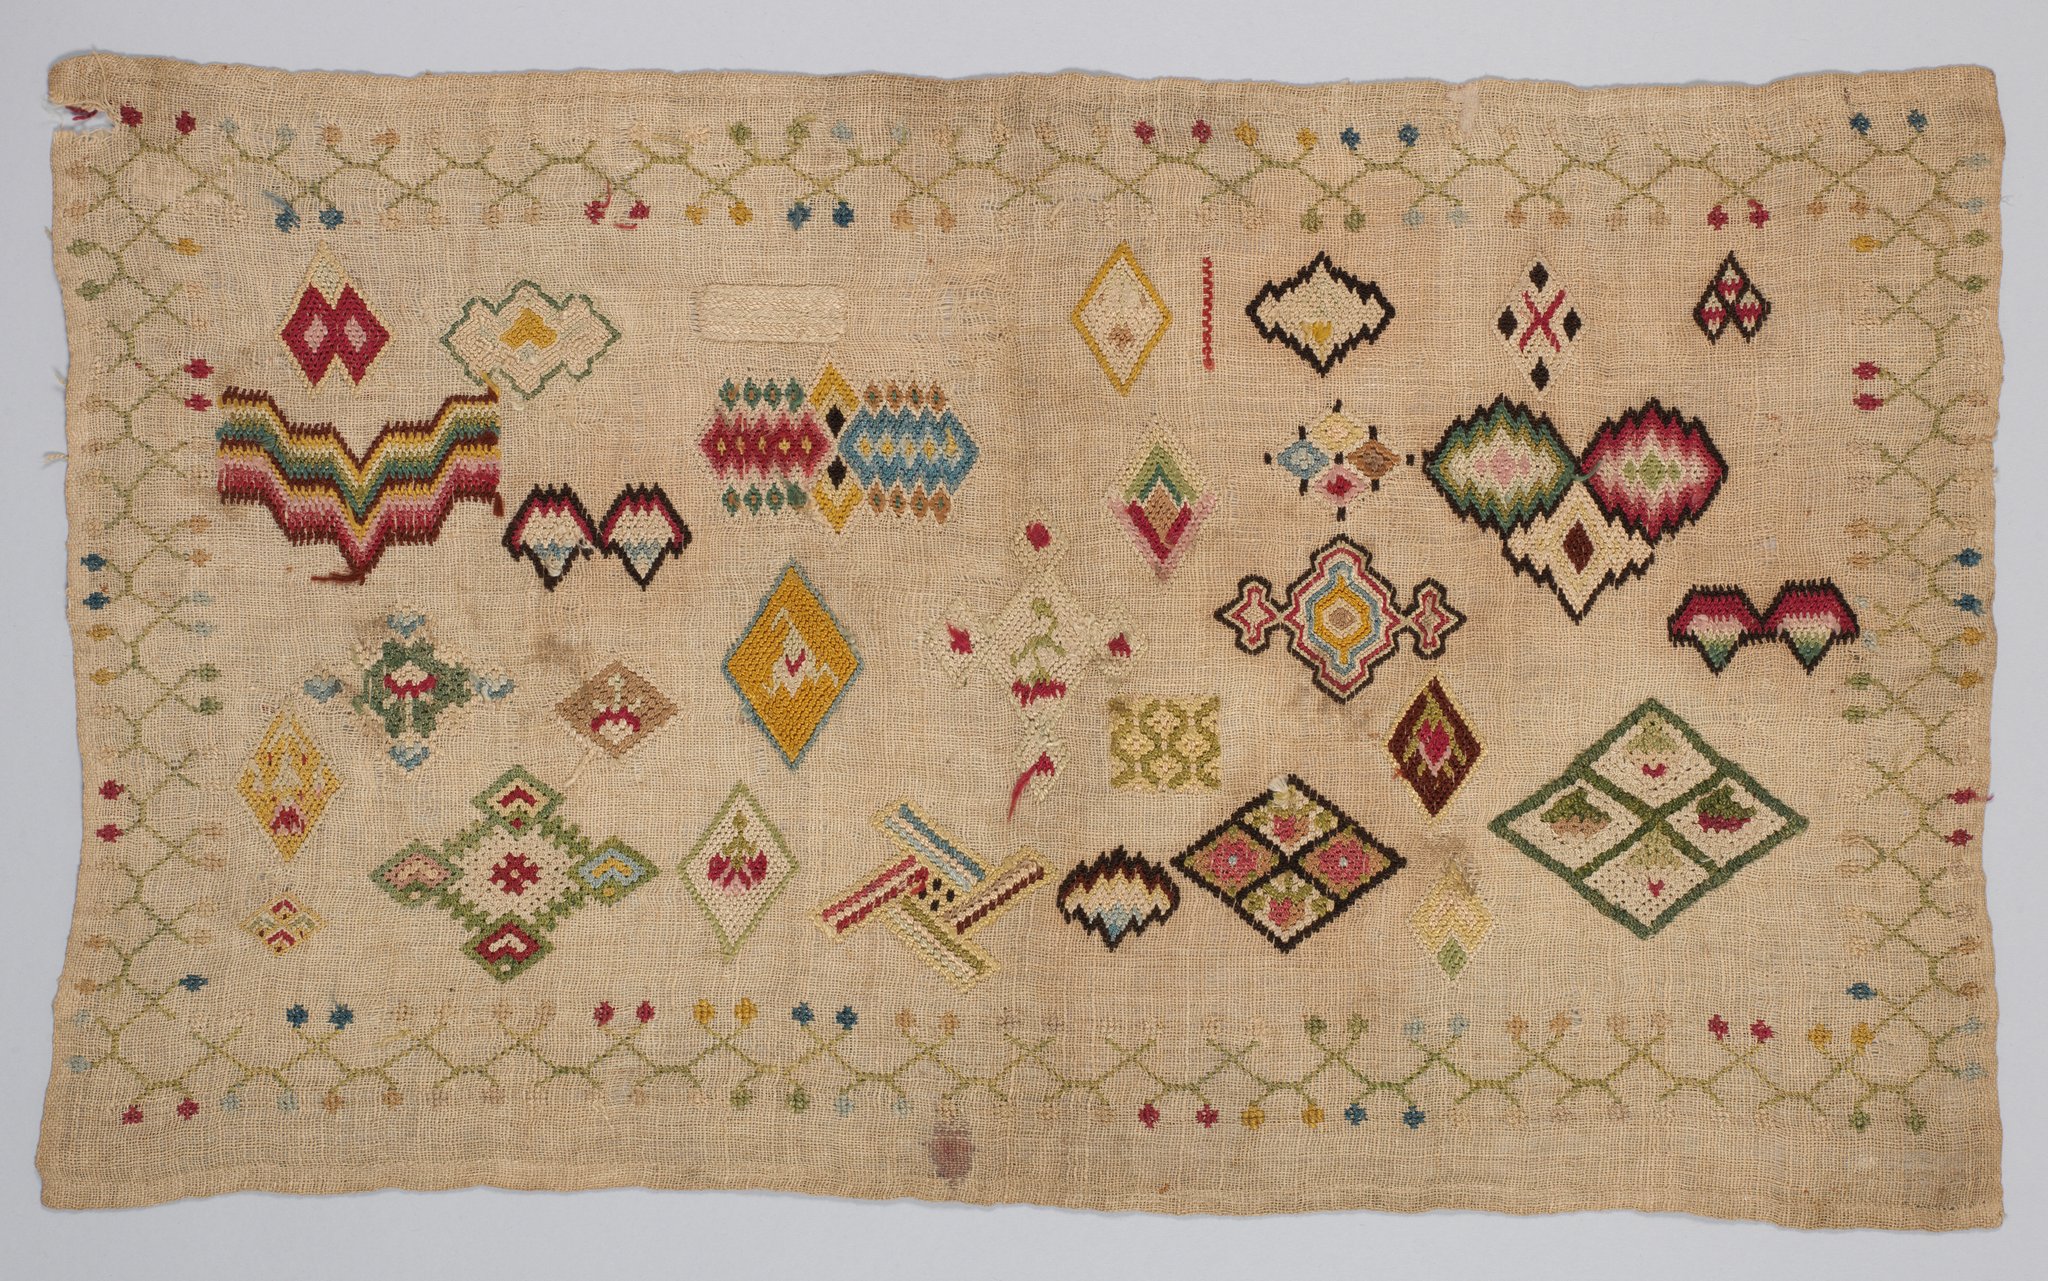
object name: sampler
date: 1701-1800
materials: canvas, linen, silk